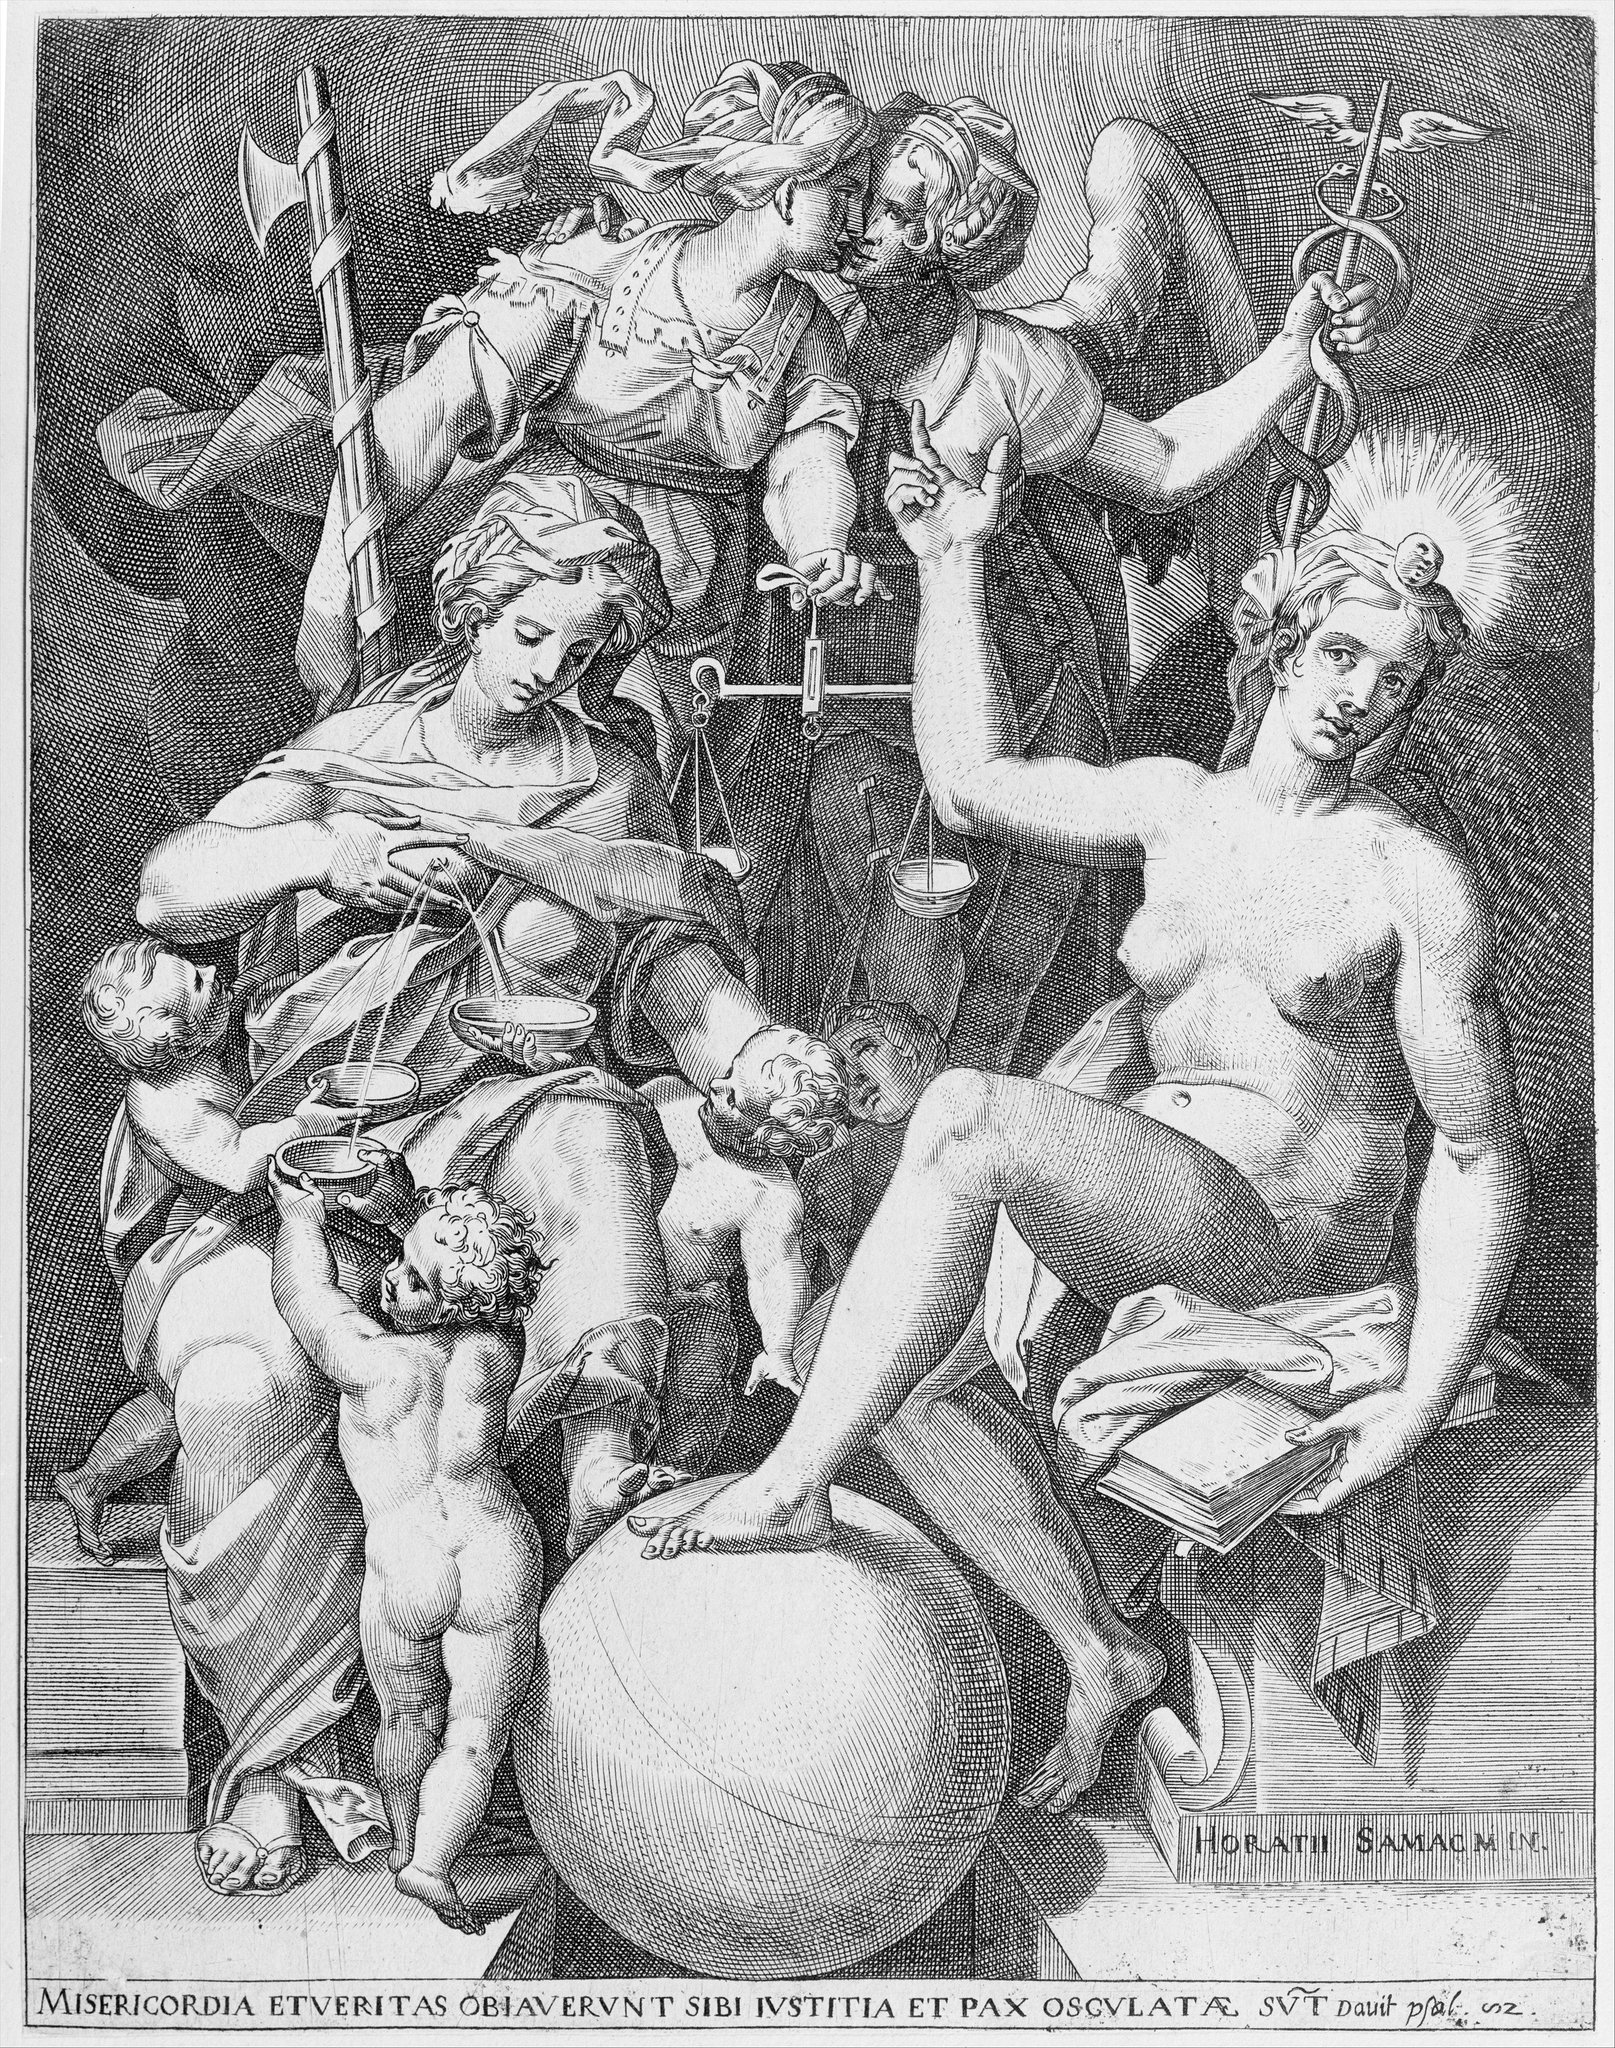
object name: print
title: Allegory of the Psalm of David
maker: agostino carracci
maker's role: artist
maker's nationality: italian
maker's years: 1557-1602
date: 1579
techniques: engraving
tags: children,women,female nudes